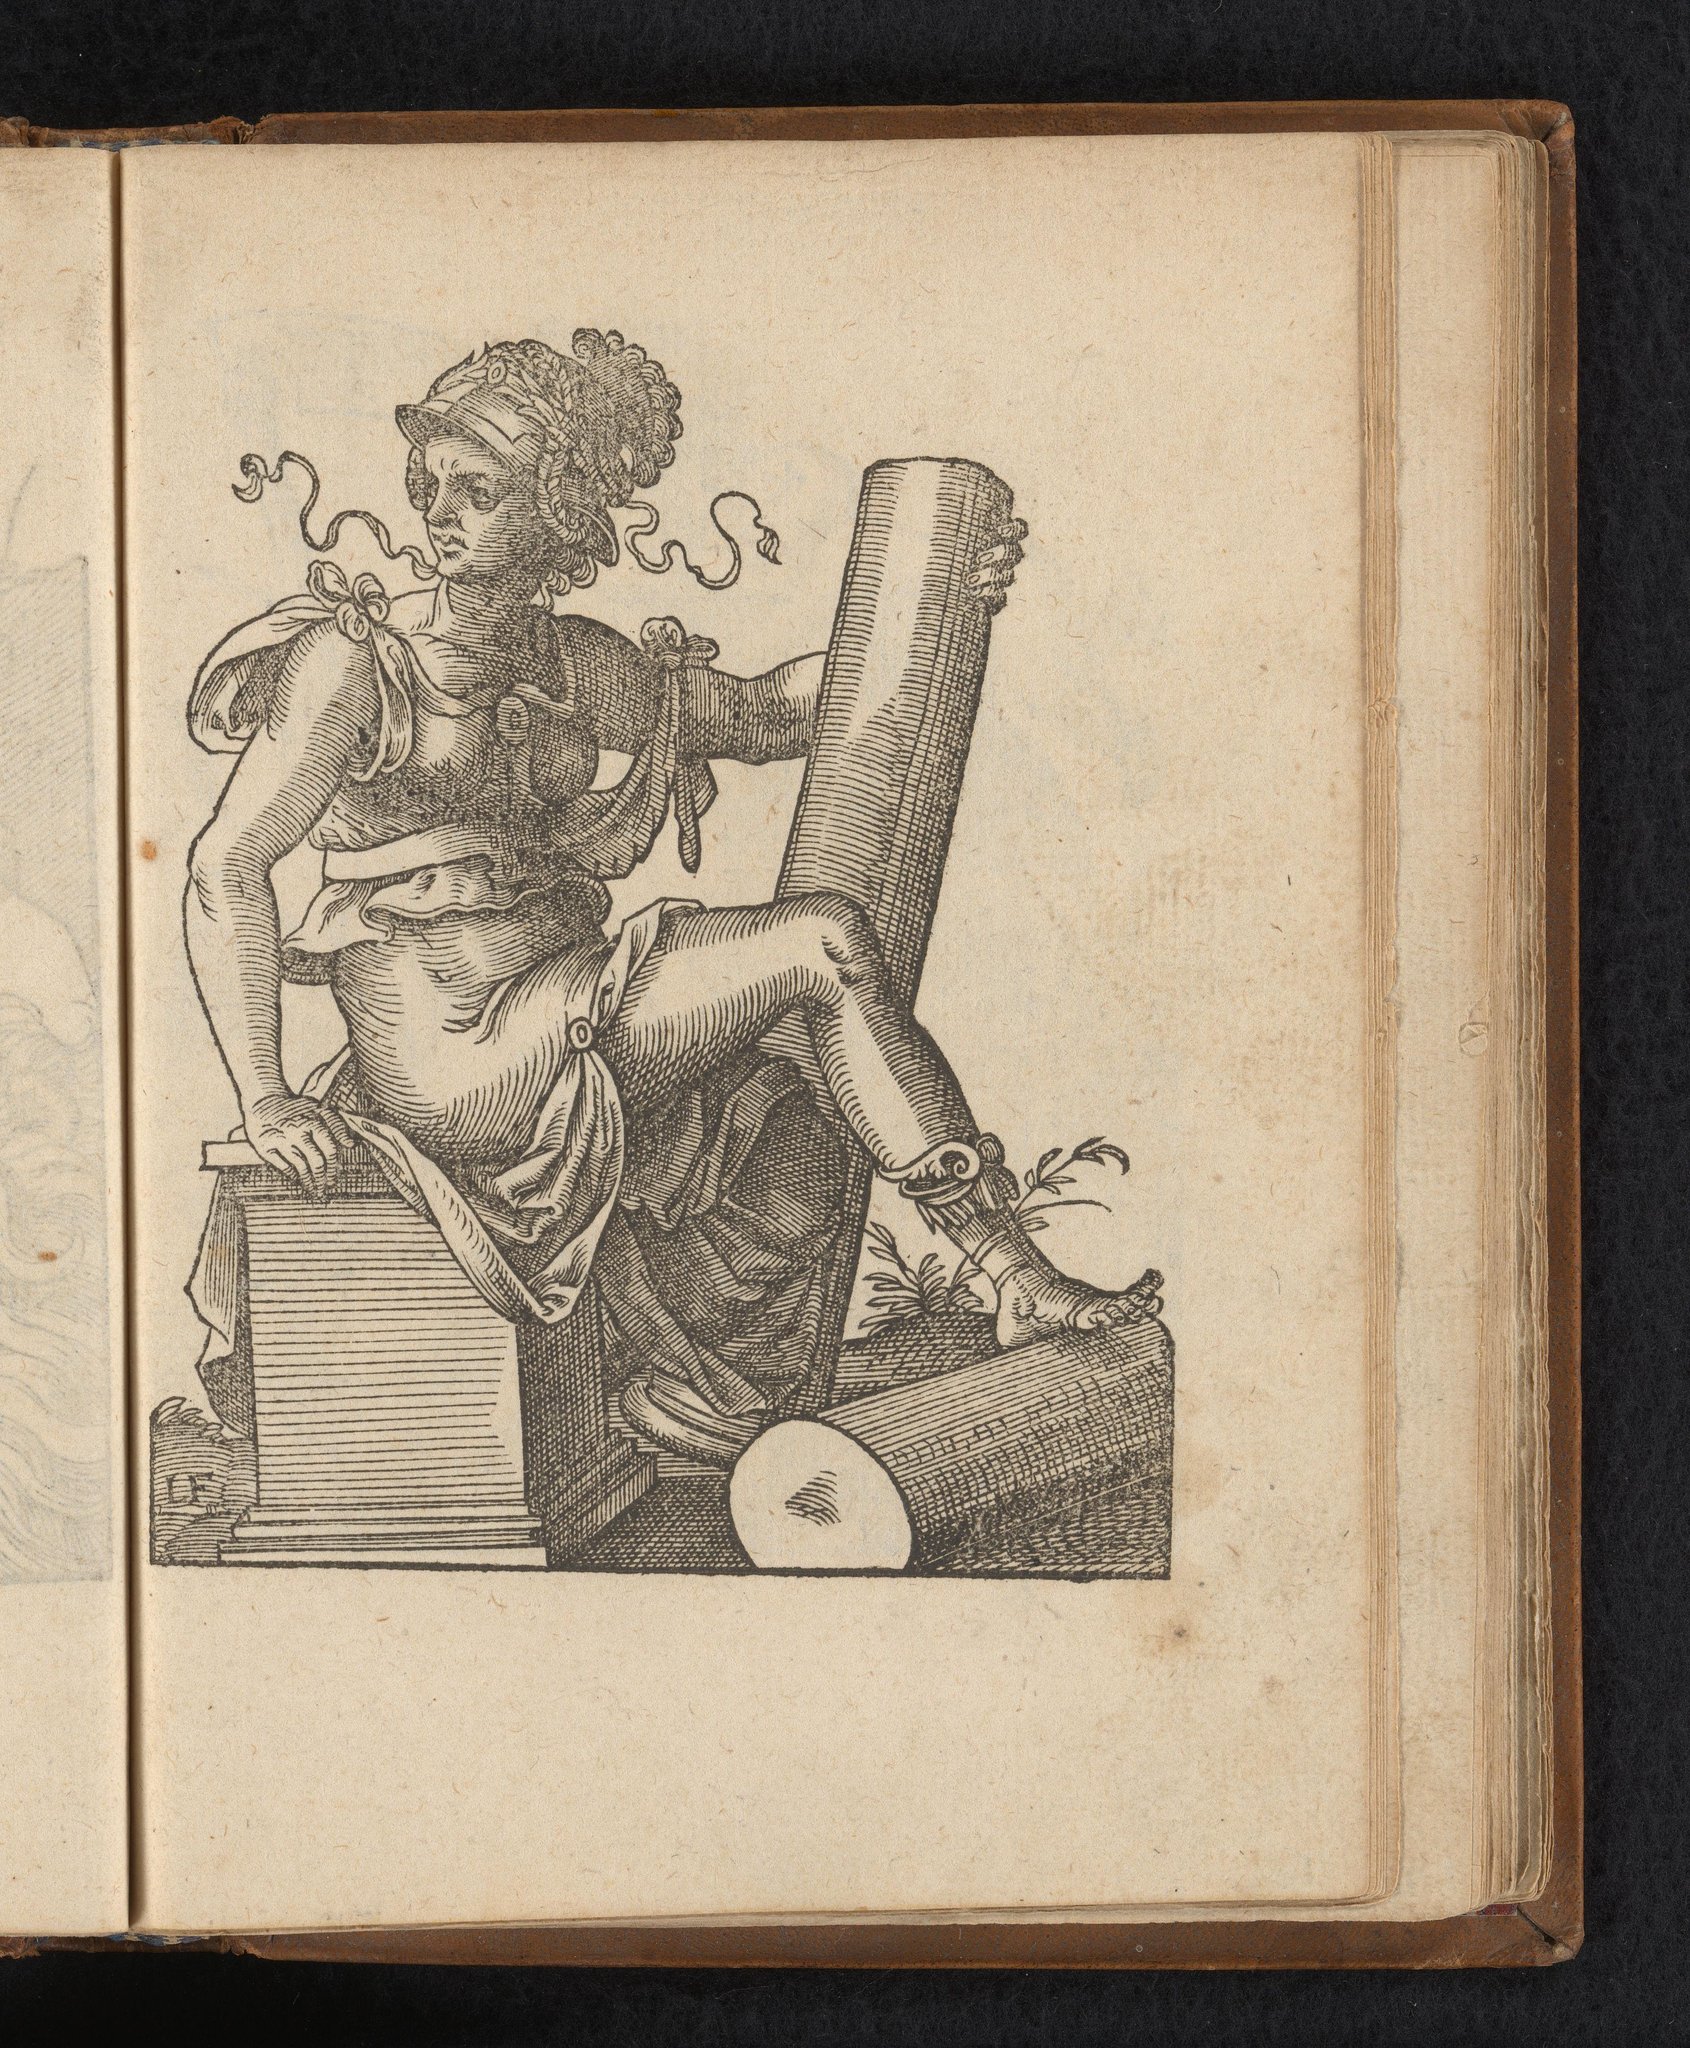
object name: print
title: Fortitudo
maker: monogrammist lf (graveur)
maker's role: houtsnijder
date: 1578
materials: paper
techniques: woodcut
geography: nuremberg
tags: fortitude, 'fortitudo' ~ one of the four cardinal virtues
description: Fortitudo, de Kracht. Onderdeel van het modelboek Enchiridion artis pingendi, fingendi & sculpendi met 108 figuren bedoeld voor beginnende schilders, beeldhouwers en prentmakers.